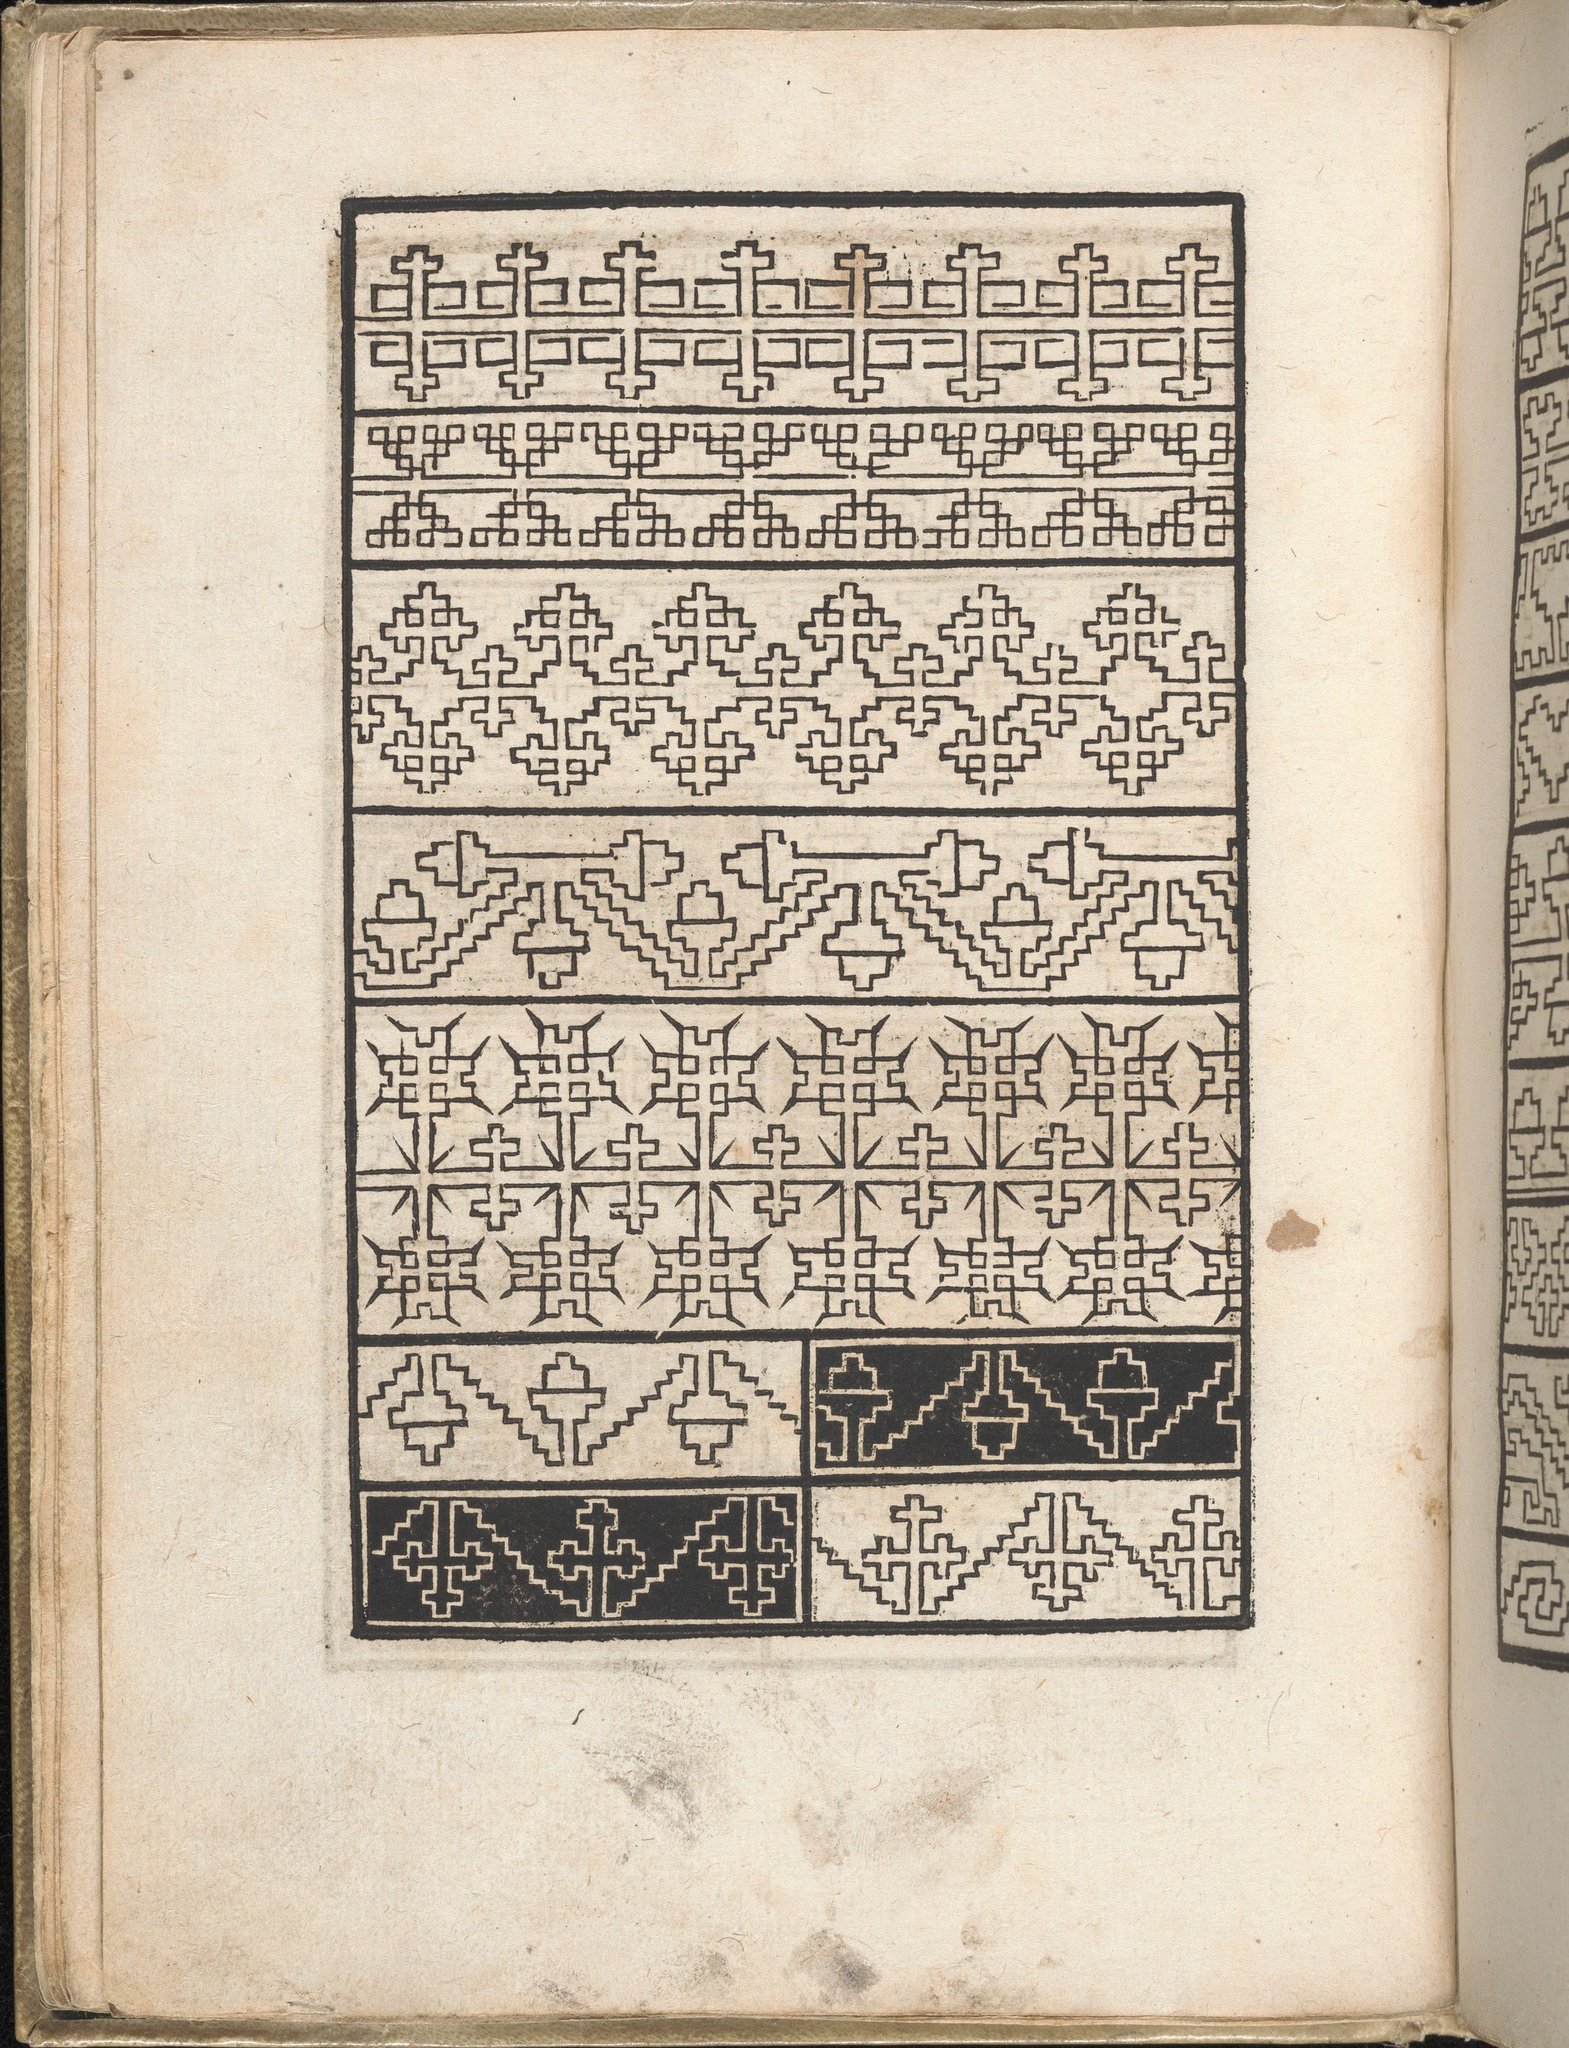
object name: book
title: Page 7r, from "Eyn New Kunstlichboich"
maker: peter quentel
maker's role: publisher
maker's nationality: german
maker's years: 1500-1550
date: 1529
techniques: woodcut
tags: ornament